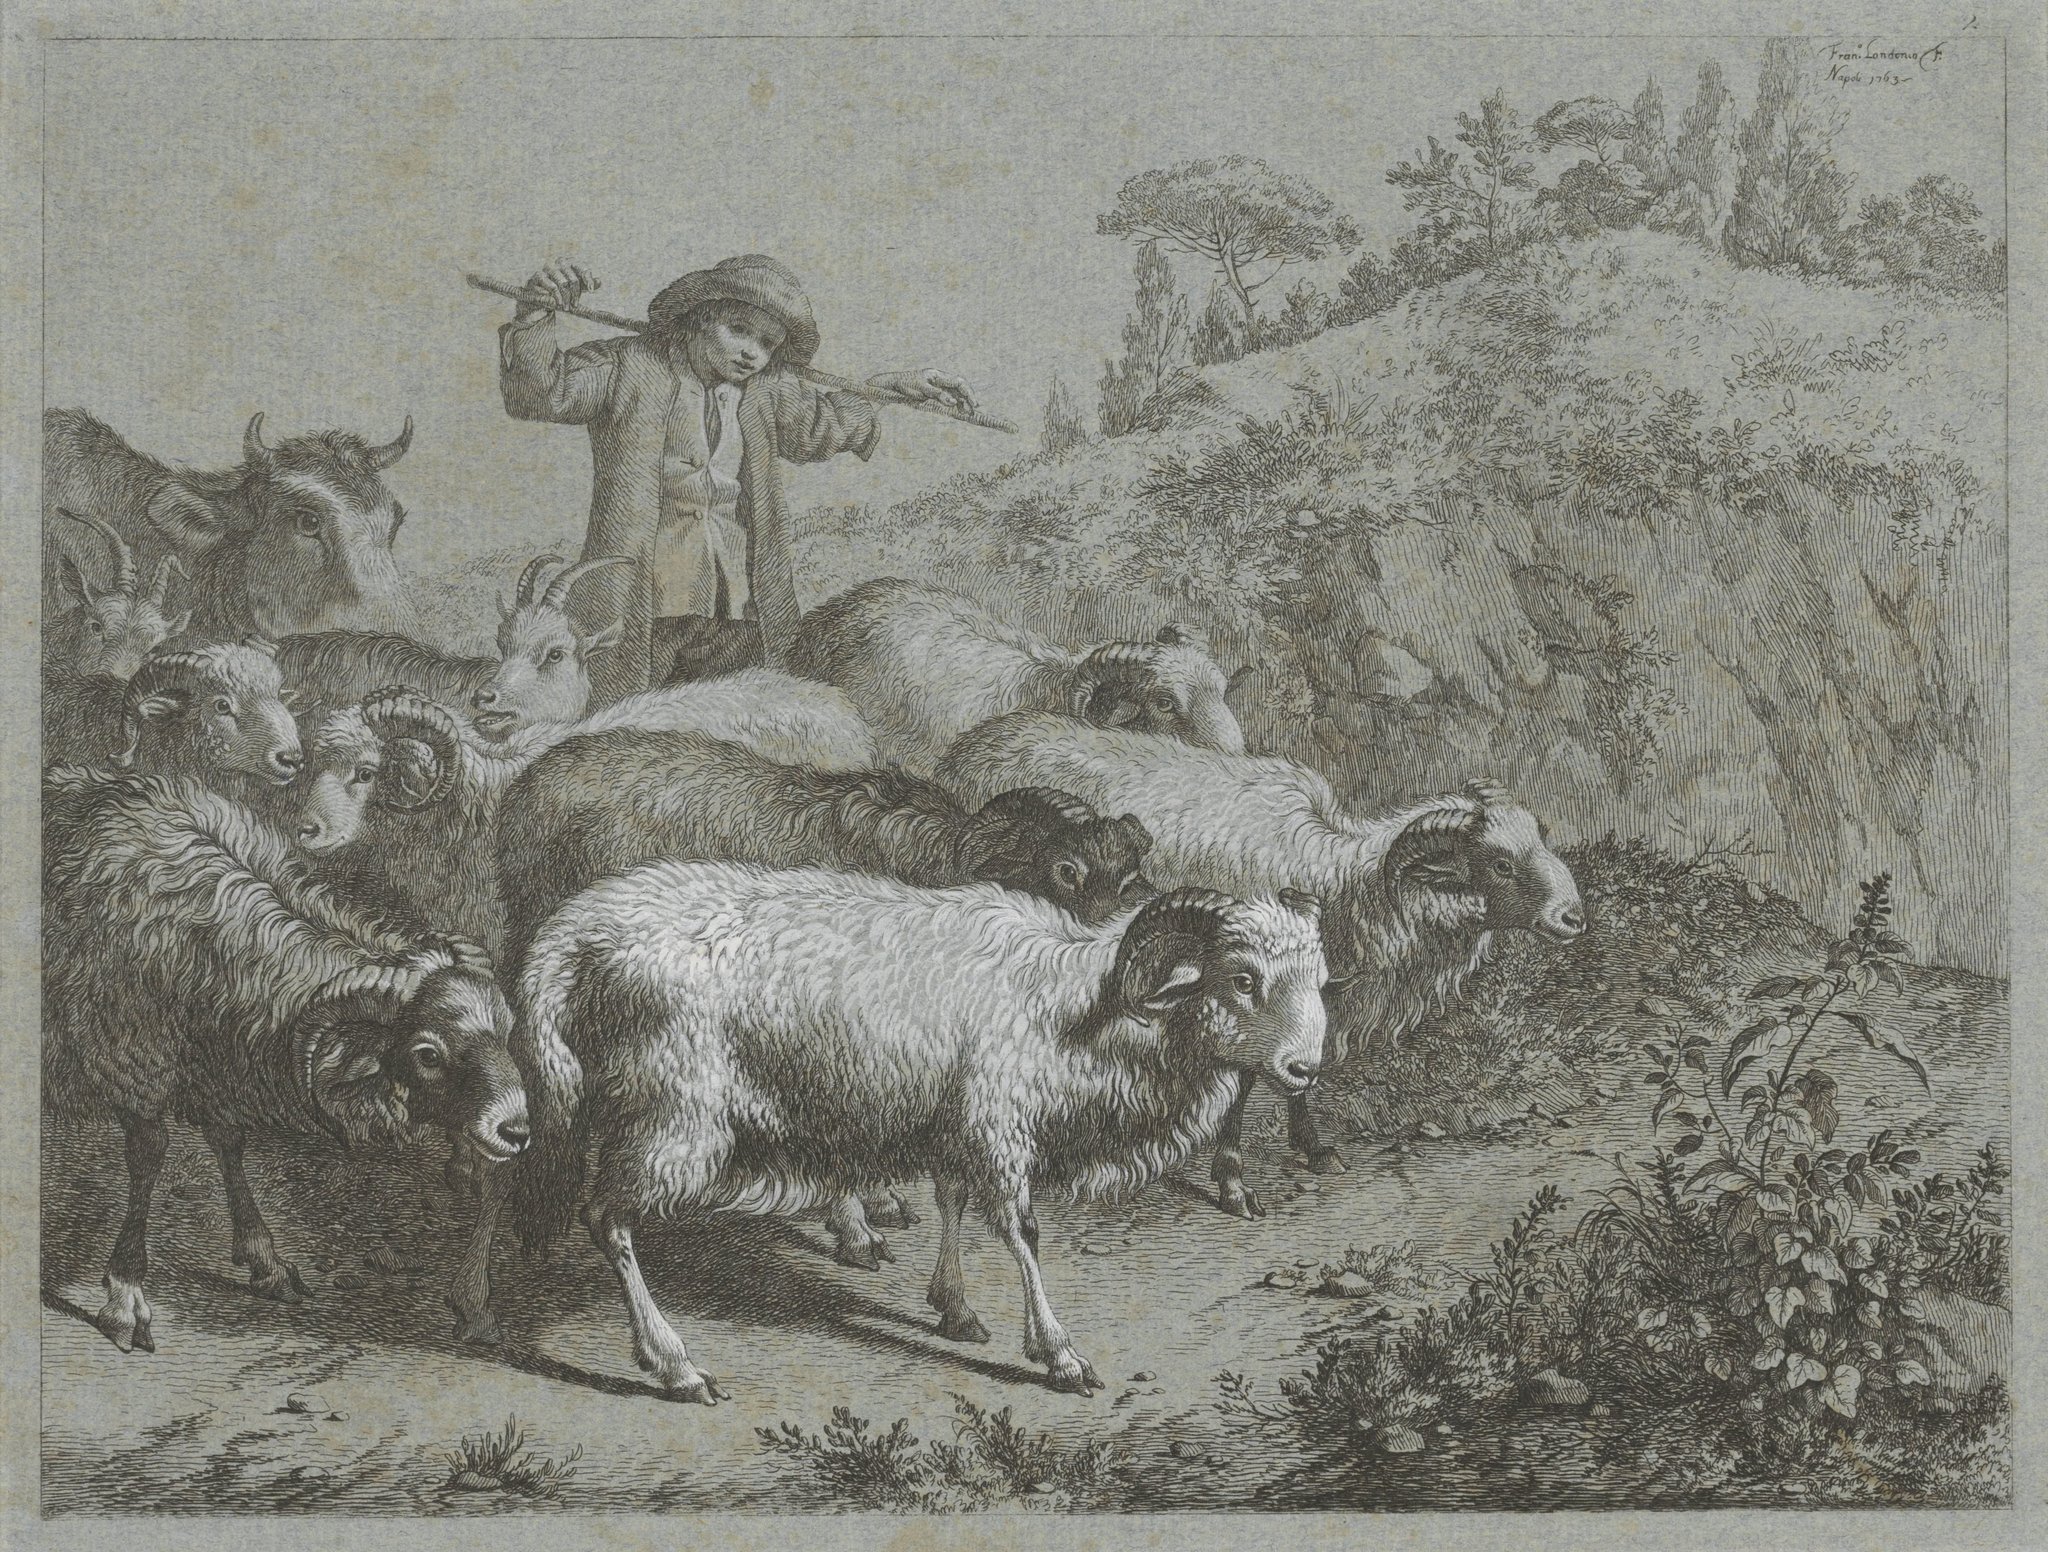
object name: print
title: Herdertaferelen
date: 1763-1764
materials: paper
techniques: etching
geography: naples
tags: cow, herding, herdsman, herdswoman, shepherd, shepherdess, cowherd, etc.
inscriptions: collector's mark: Lugt 240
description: Een herder met een kudde rammen, geiten en een koe in een heuvellandschap.